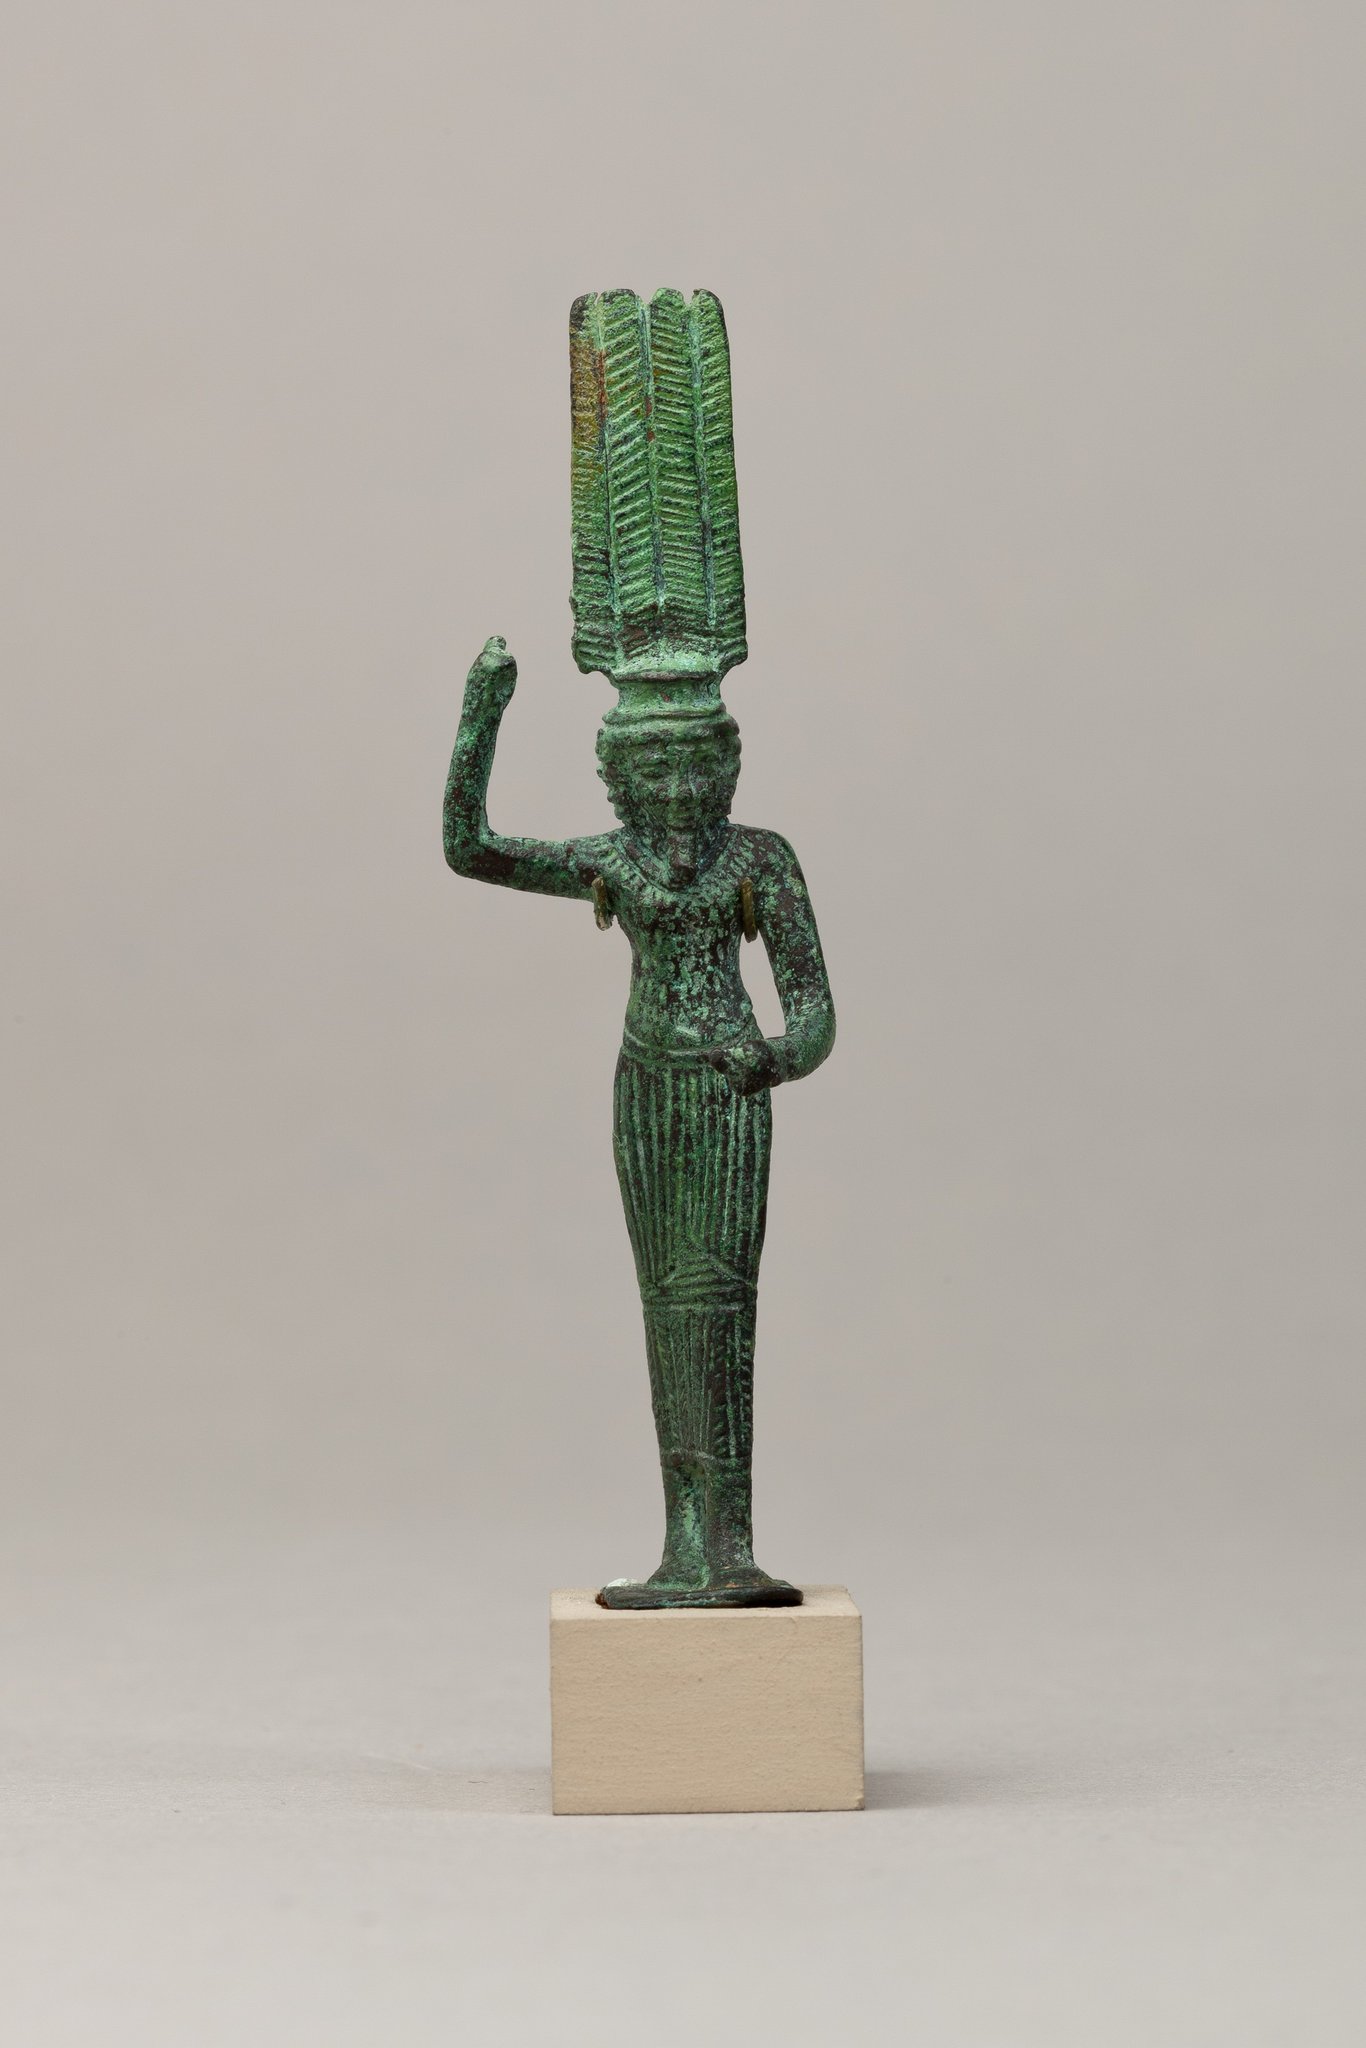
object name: statuette, onuris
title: Onuris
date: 664-332 BCE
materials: metal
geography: egypt